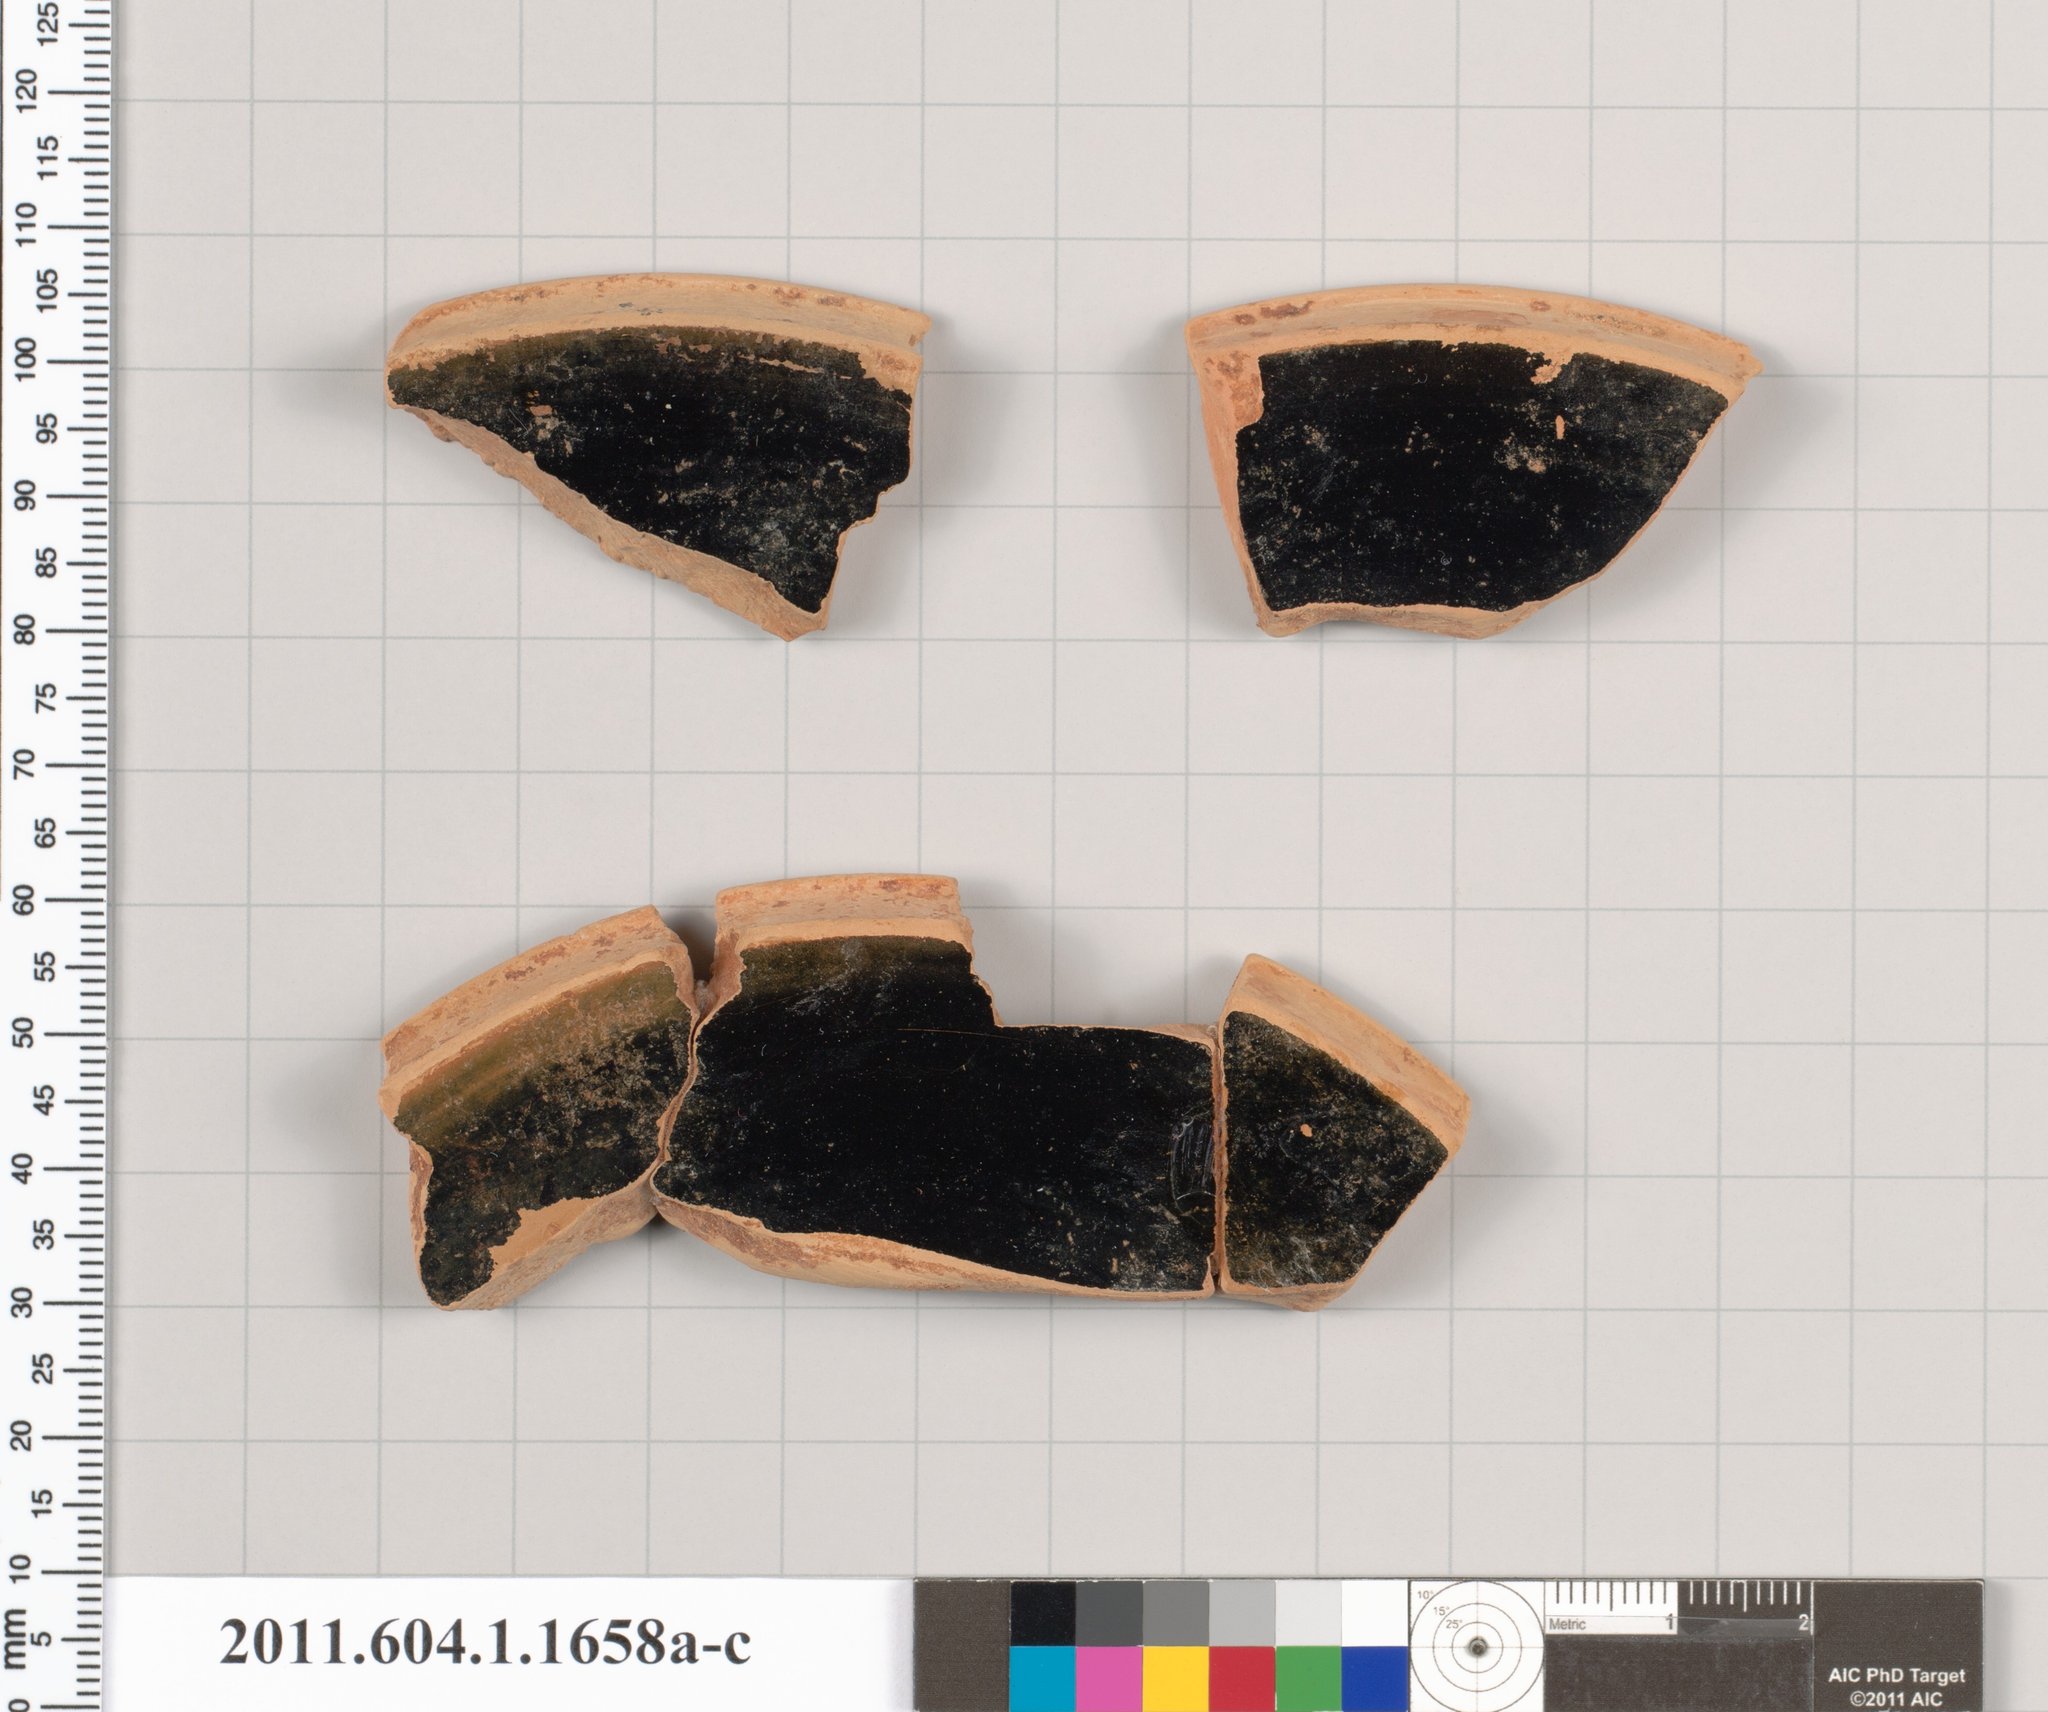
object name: kylix fragment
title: Terracotta fragments of a kylix (drinking cup)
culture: greek, attic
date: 530-510 BCE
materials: terracotta